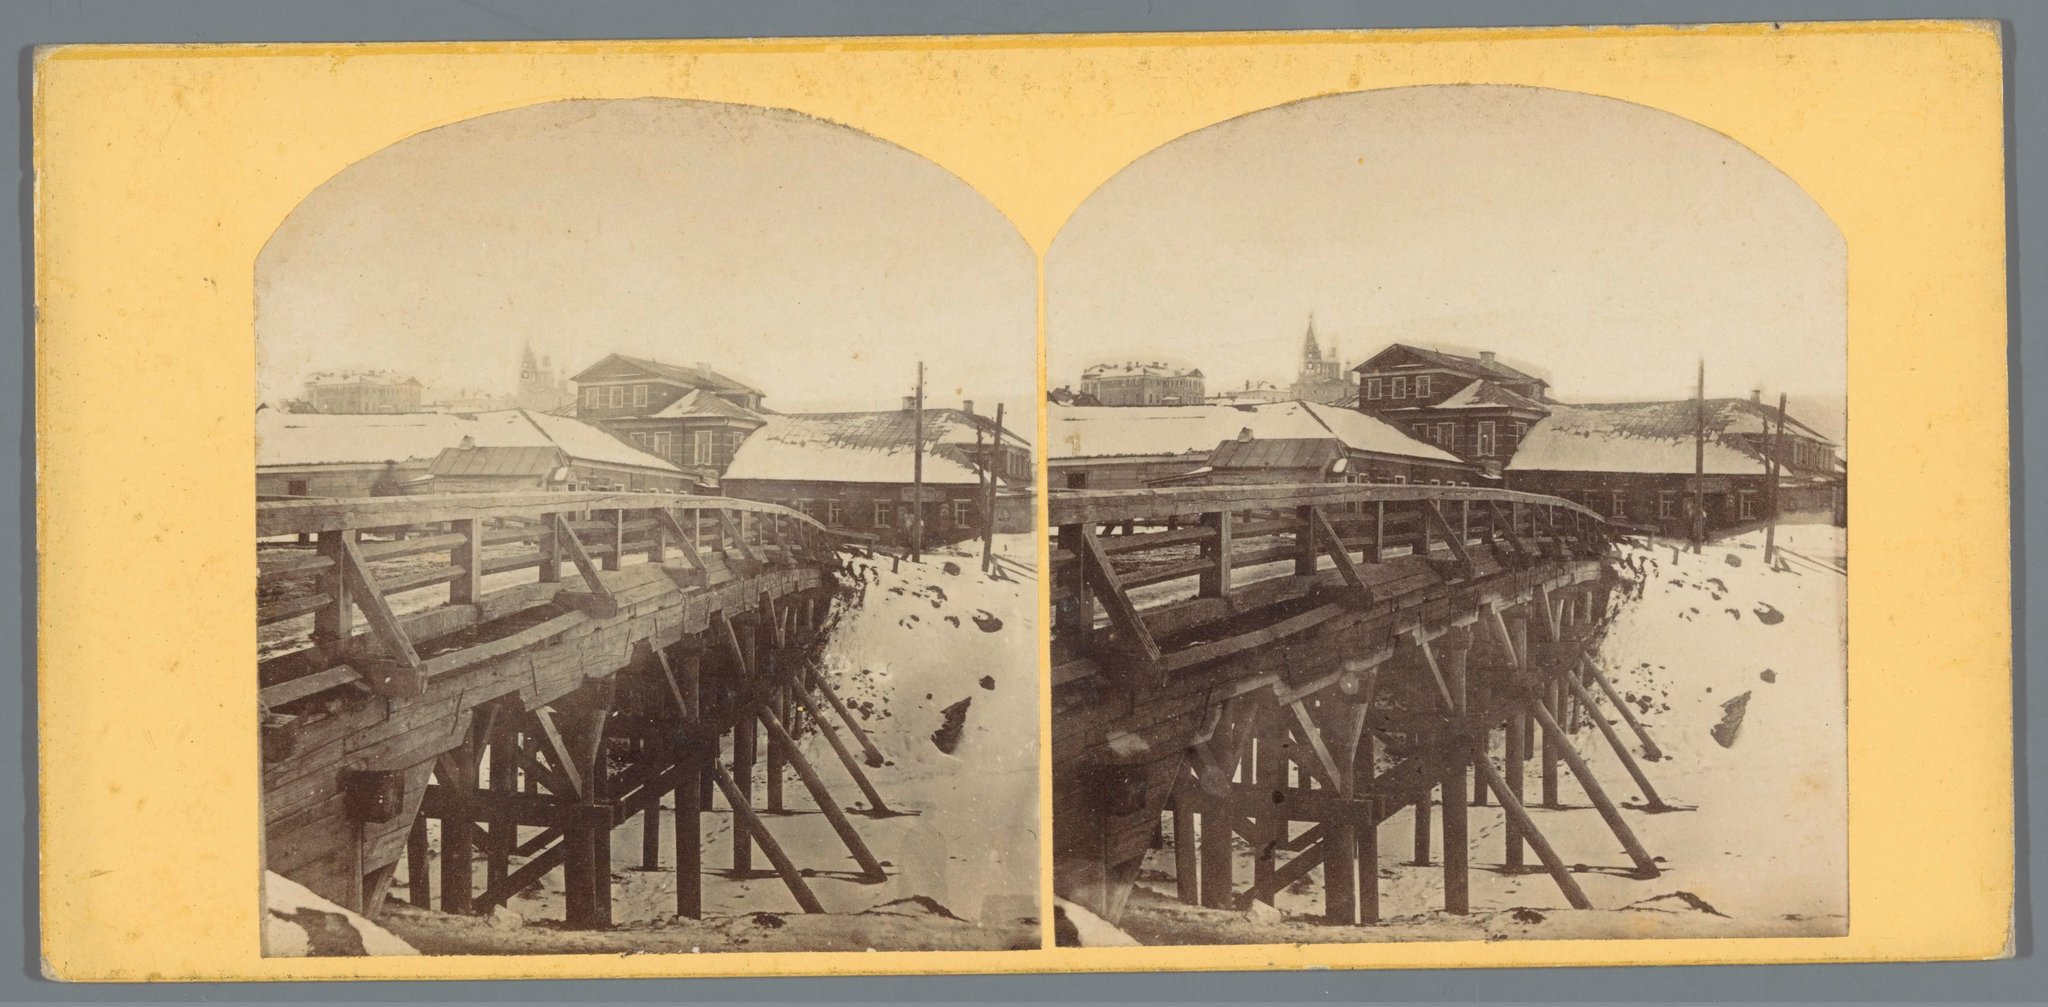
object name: stereograph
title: Effet de neige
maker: Anonymous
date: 1861-1870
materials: cardboard, paper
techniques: albumen print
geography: finland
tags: winter landscape; landscape symbolizing winter (the four seasons of the year)